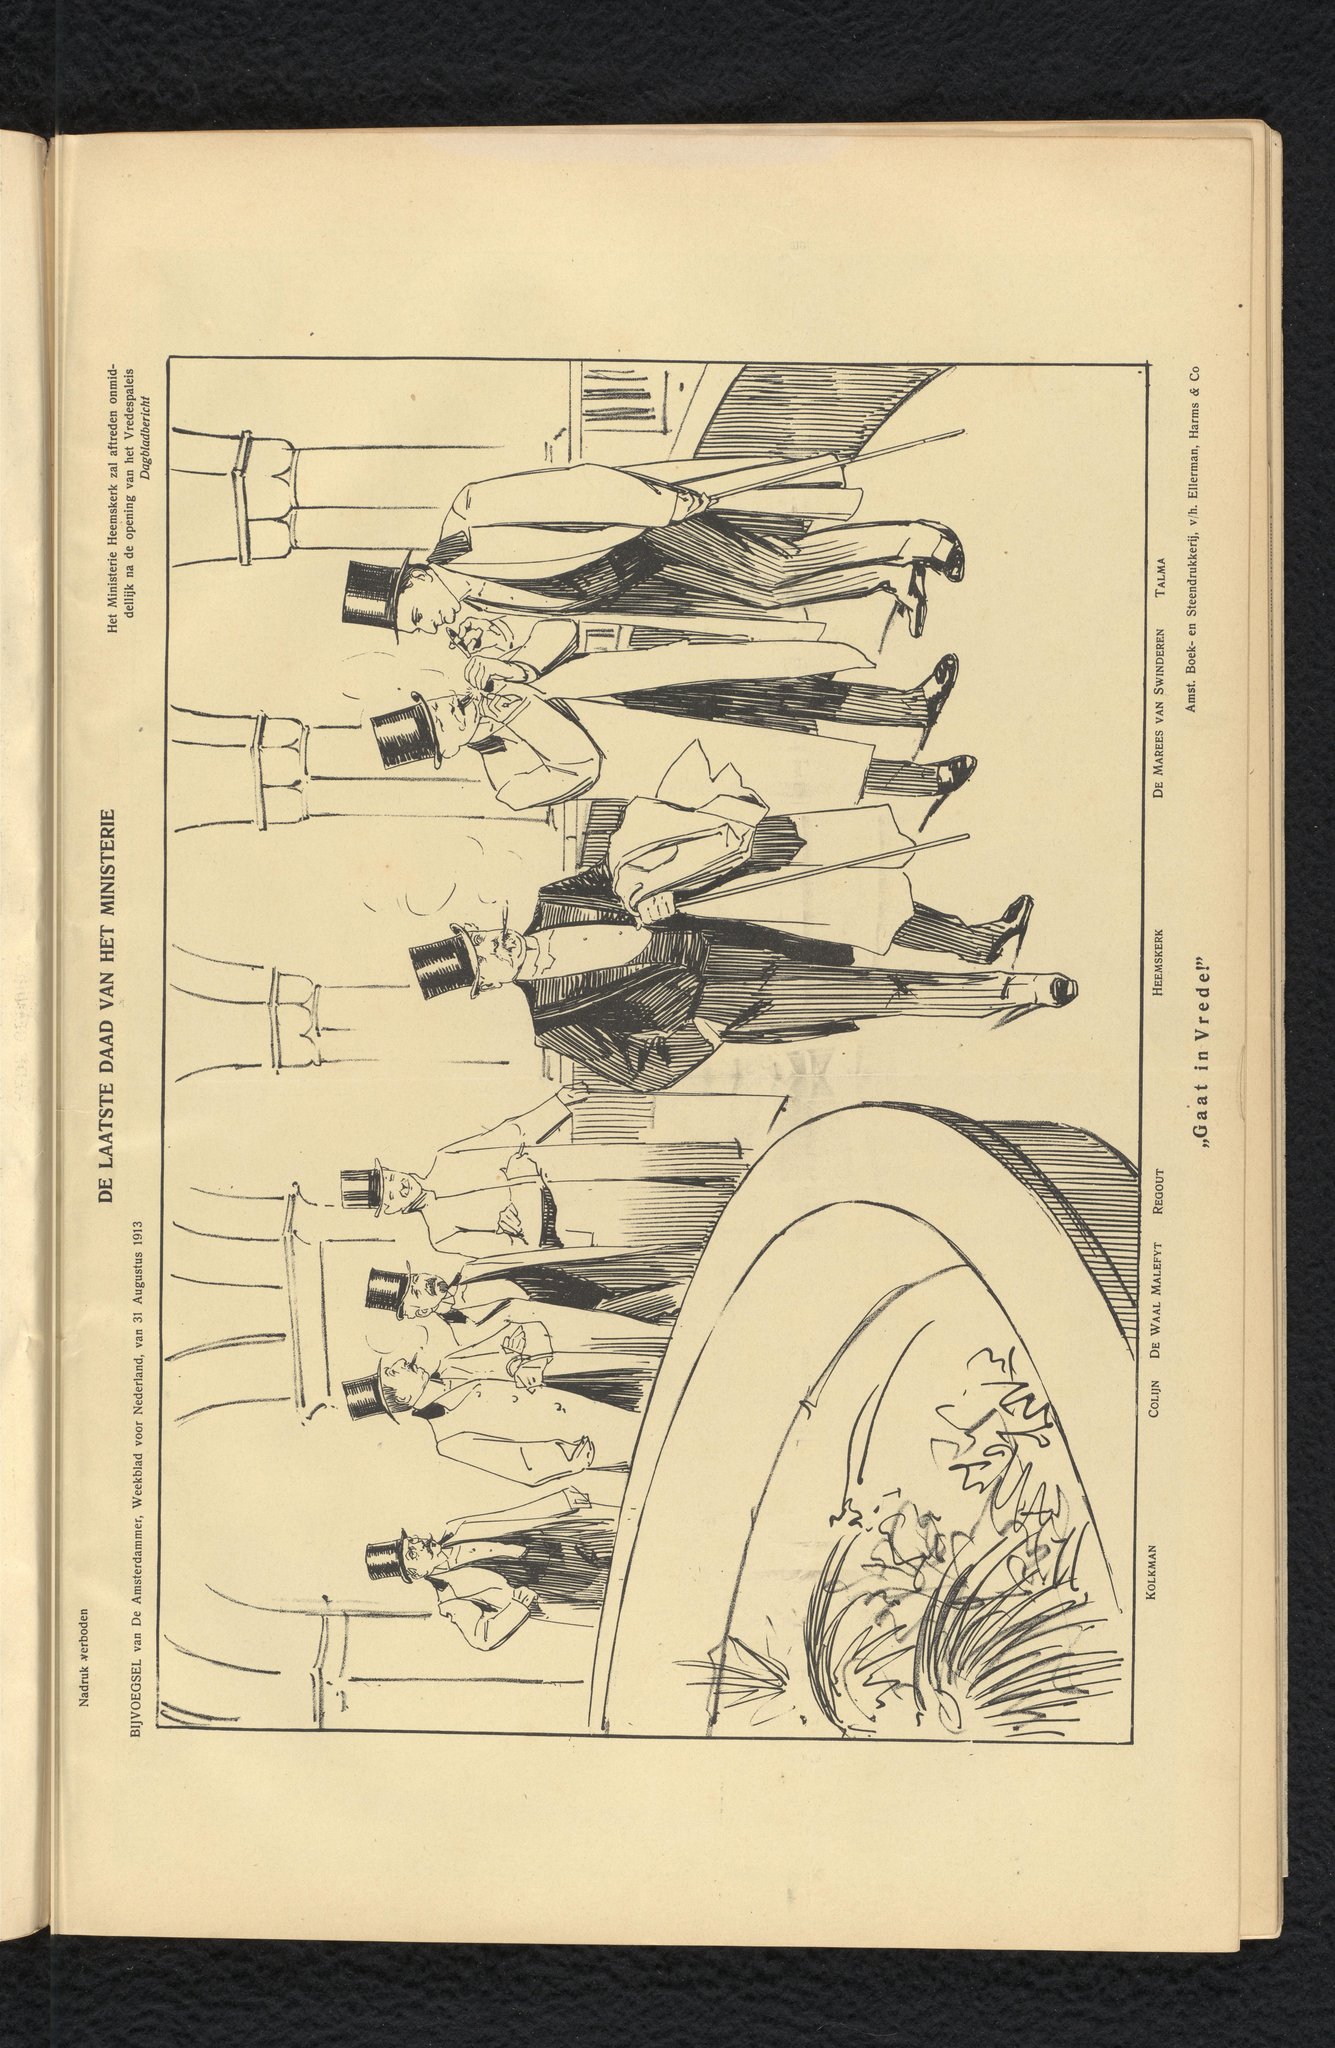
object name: cartoon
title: De laatste daad van het ministerie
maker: johan braakensiek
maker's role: draughtsman, print maker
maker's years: 1858-1940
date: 1913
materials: paper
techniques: lithograph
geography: netherlands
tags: groningen (province), london, amsterdam, utrecht, maastricht, dordrecht, the hague, politician, hendrikus colijn, minister ~ government, cigar, political caricatures and satires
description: Het kabinet Heemskerk treedt af direct na de opening van het Vredespaleis in Den Haag. De ministers steken een sigaar op en vertrekken.